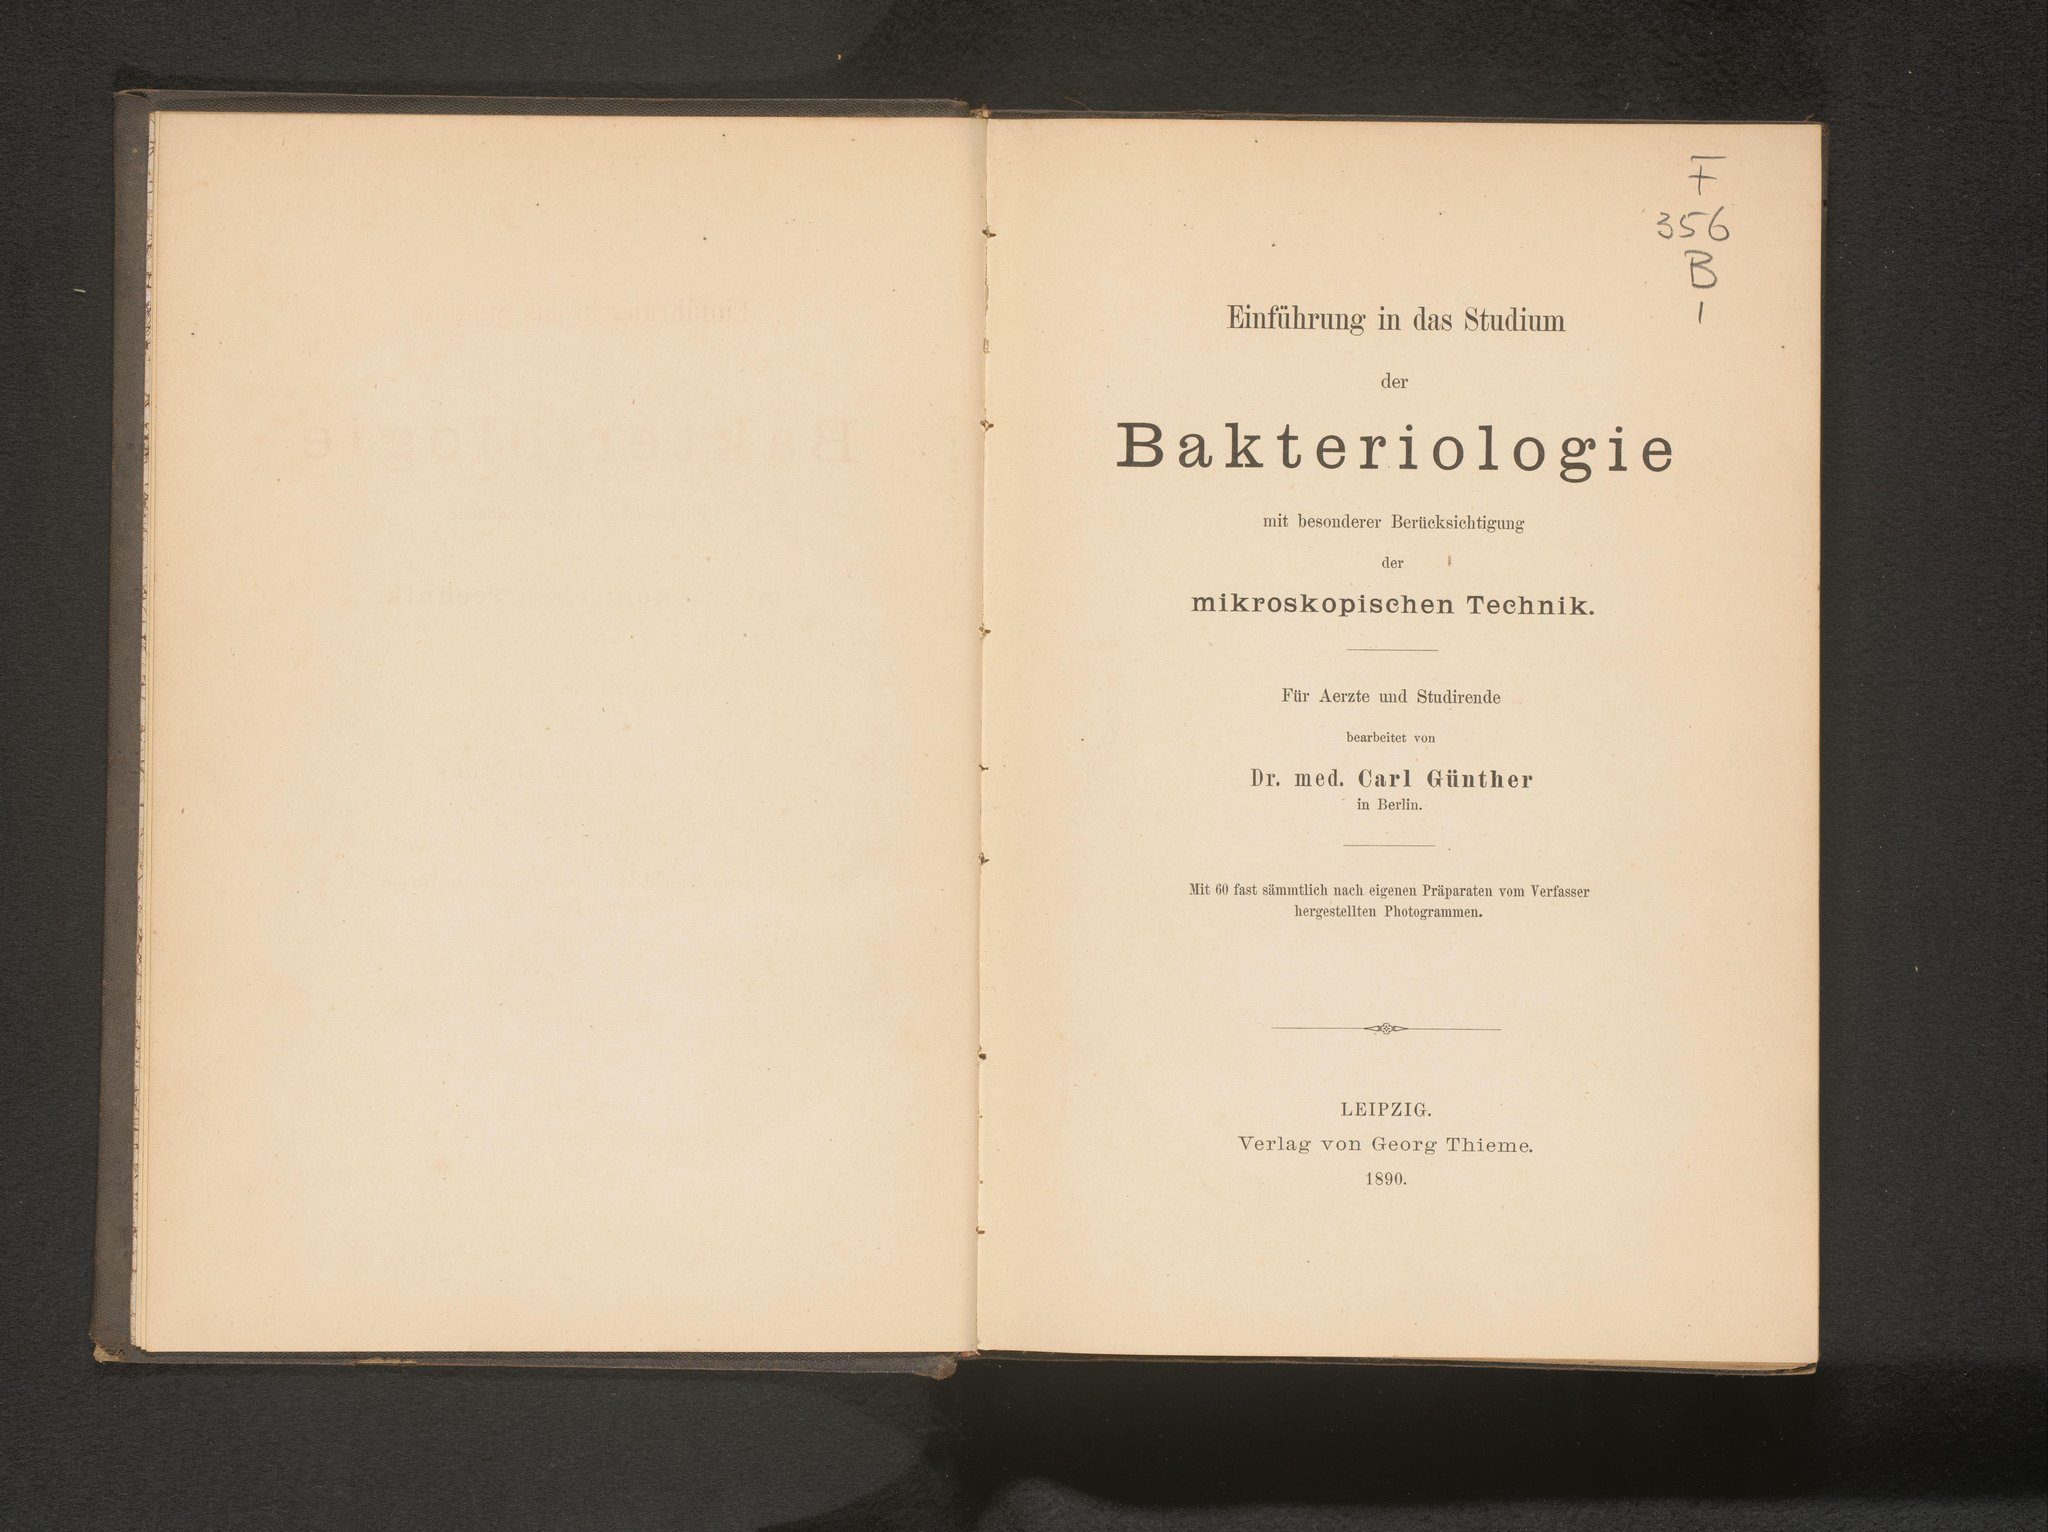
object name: book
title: Einführung in das Studium der Bakteriologie mit besonderer Berüchsichtigung der mikroskopischen Technik für Arzte und Studirende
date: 1890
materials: linen, paper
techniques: photograph, marbling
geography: leipzig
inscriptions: inscription: ‘Dr. M. Lechle [...] 94 Laizingen’